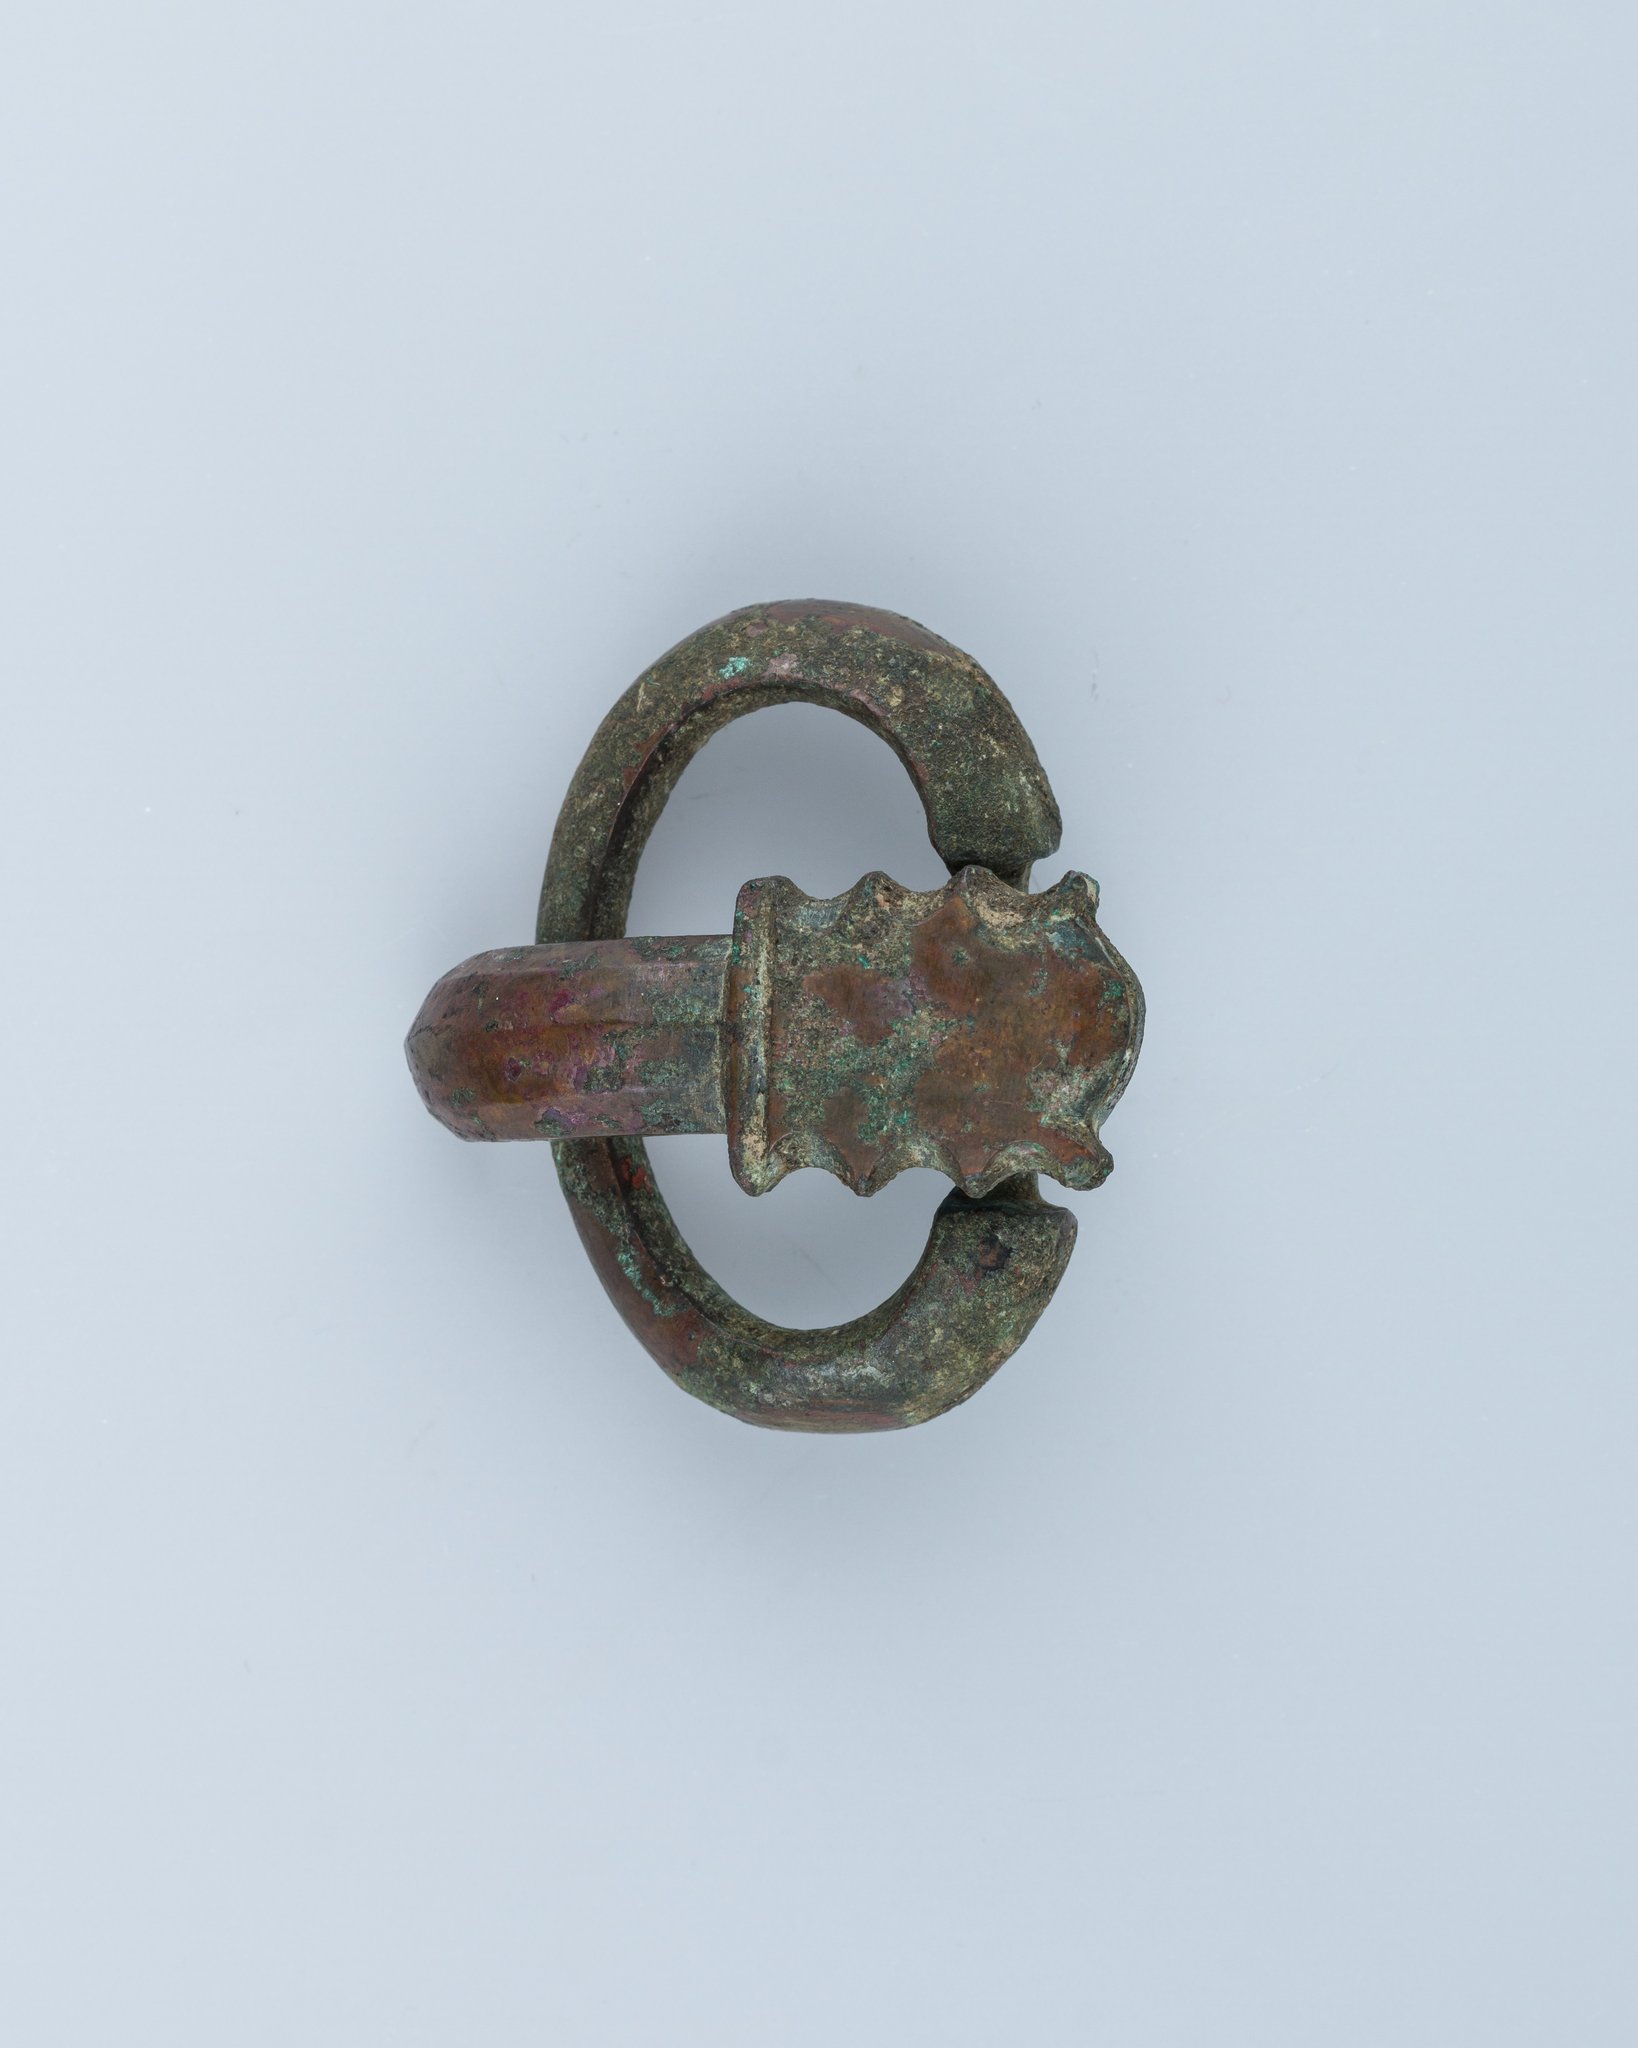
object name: buckle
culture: ibero-roman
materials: bronze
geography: spain or portugal